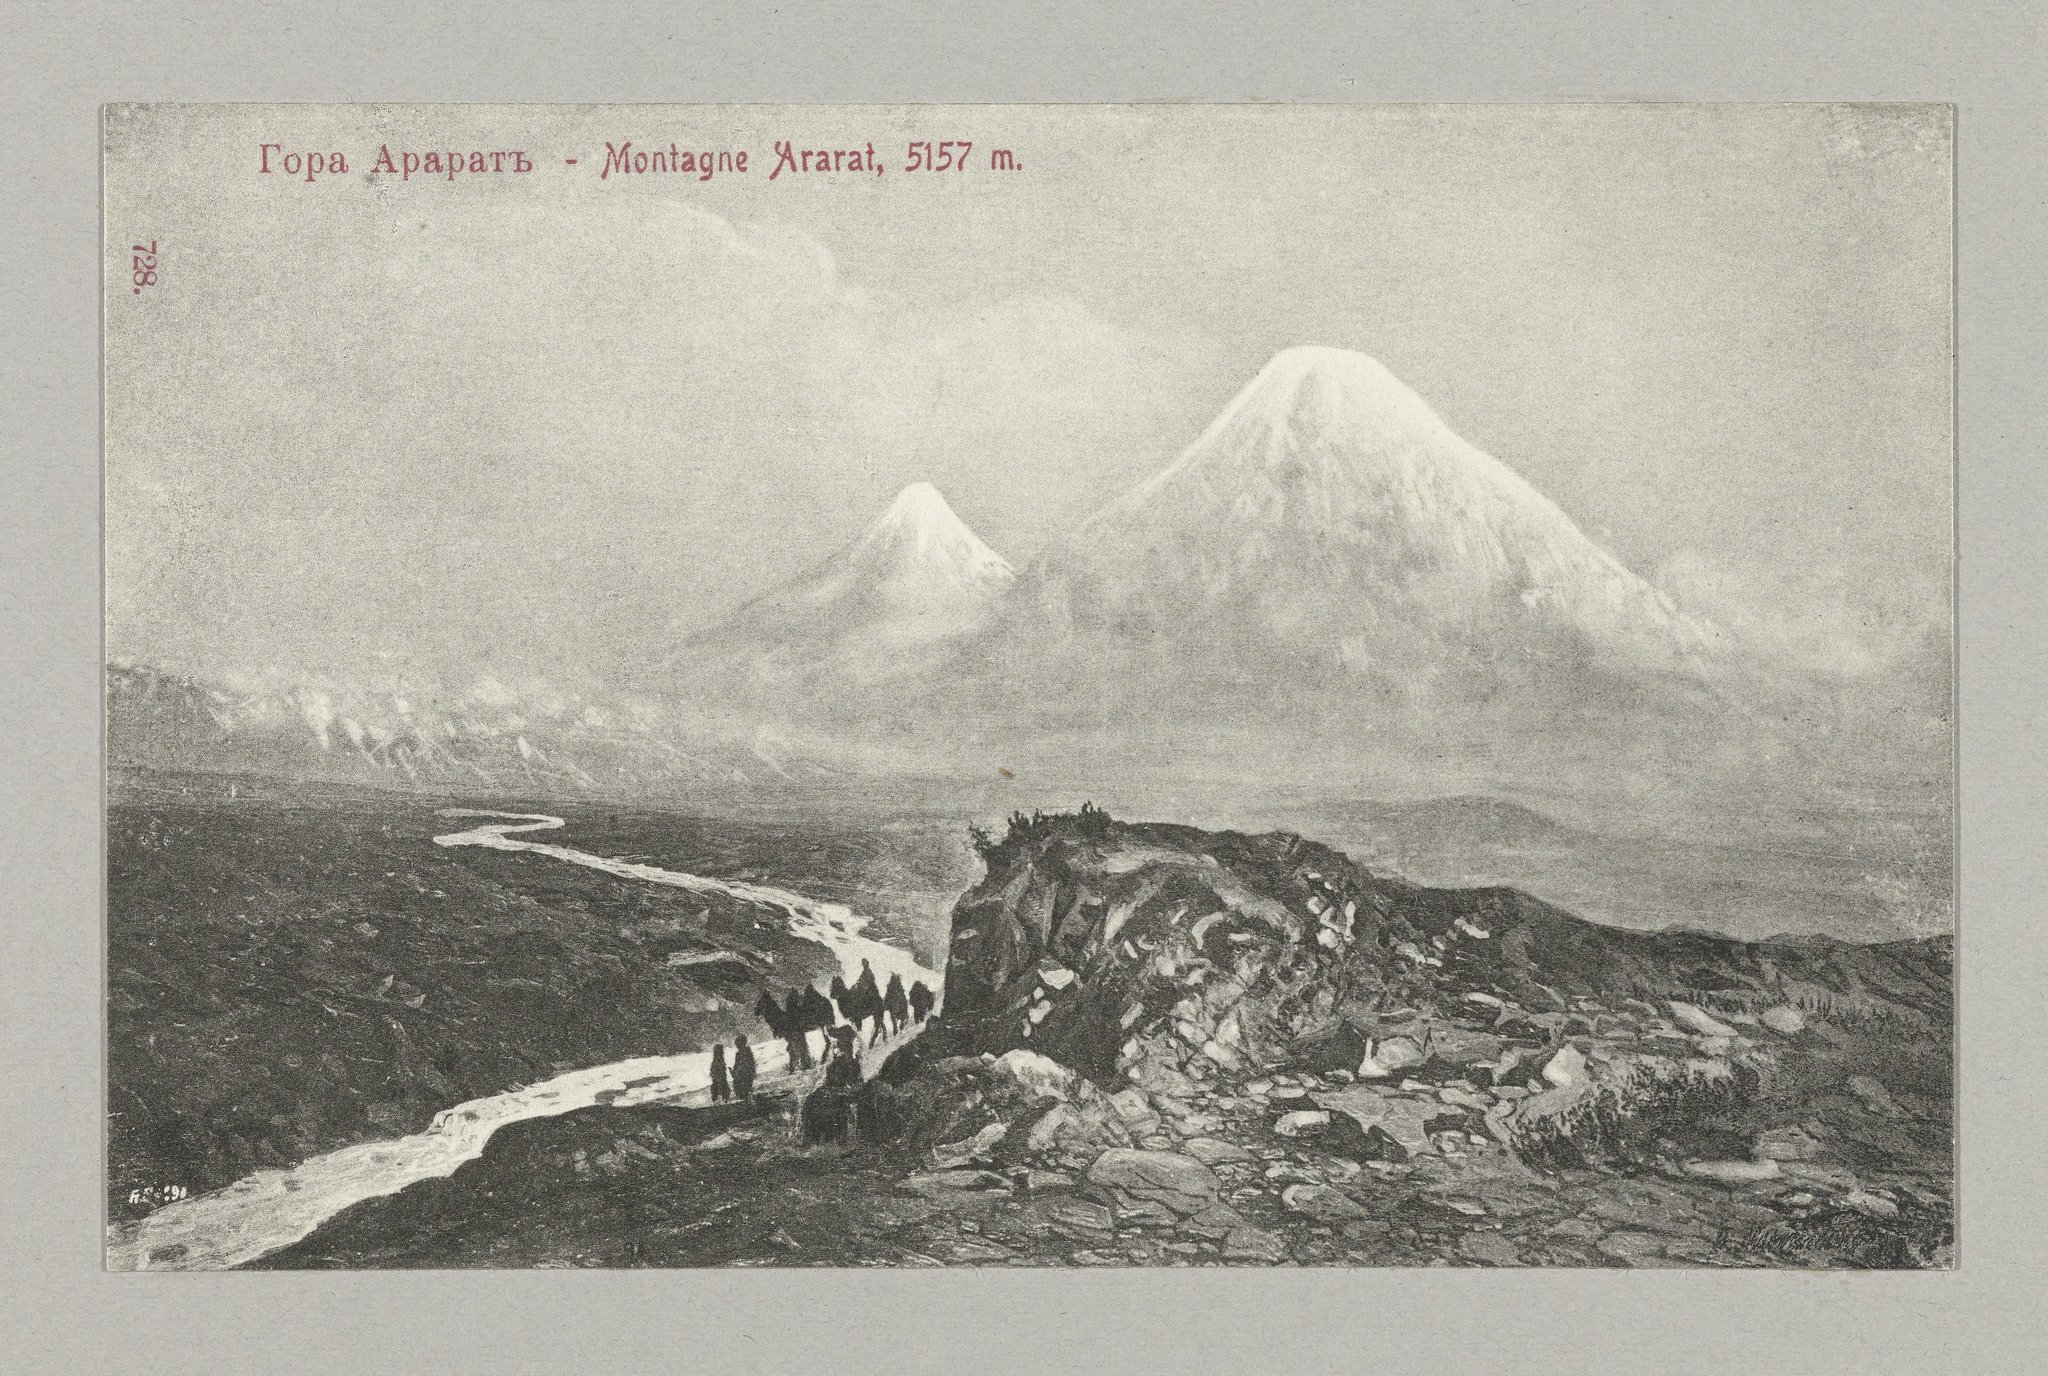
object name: photomechanical print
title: Berg Ararat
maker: Anonymous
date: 1895-1915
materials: cardboard, paper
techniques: photograph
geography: ararat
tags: ararat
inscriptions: annotation: ‘33. Weg naar Tabris (Perzië)’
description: De berg Ararat met op de voorgrond mensen en kamelen naast een rivier. Linksboven staat de titel in het Russisch en in het Frans, daarnaast staat verticaal het nummer 728 en linksonder A89298 (?).